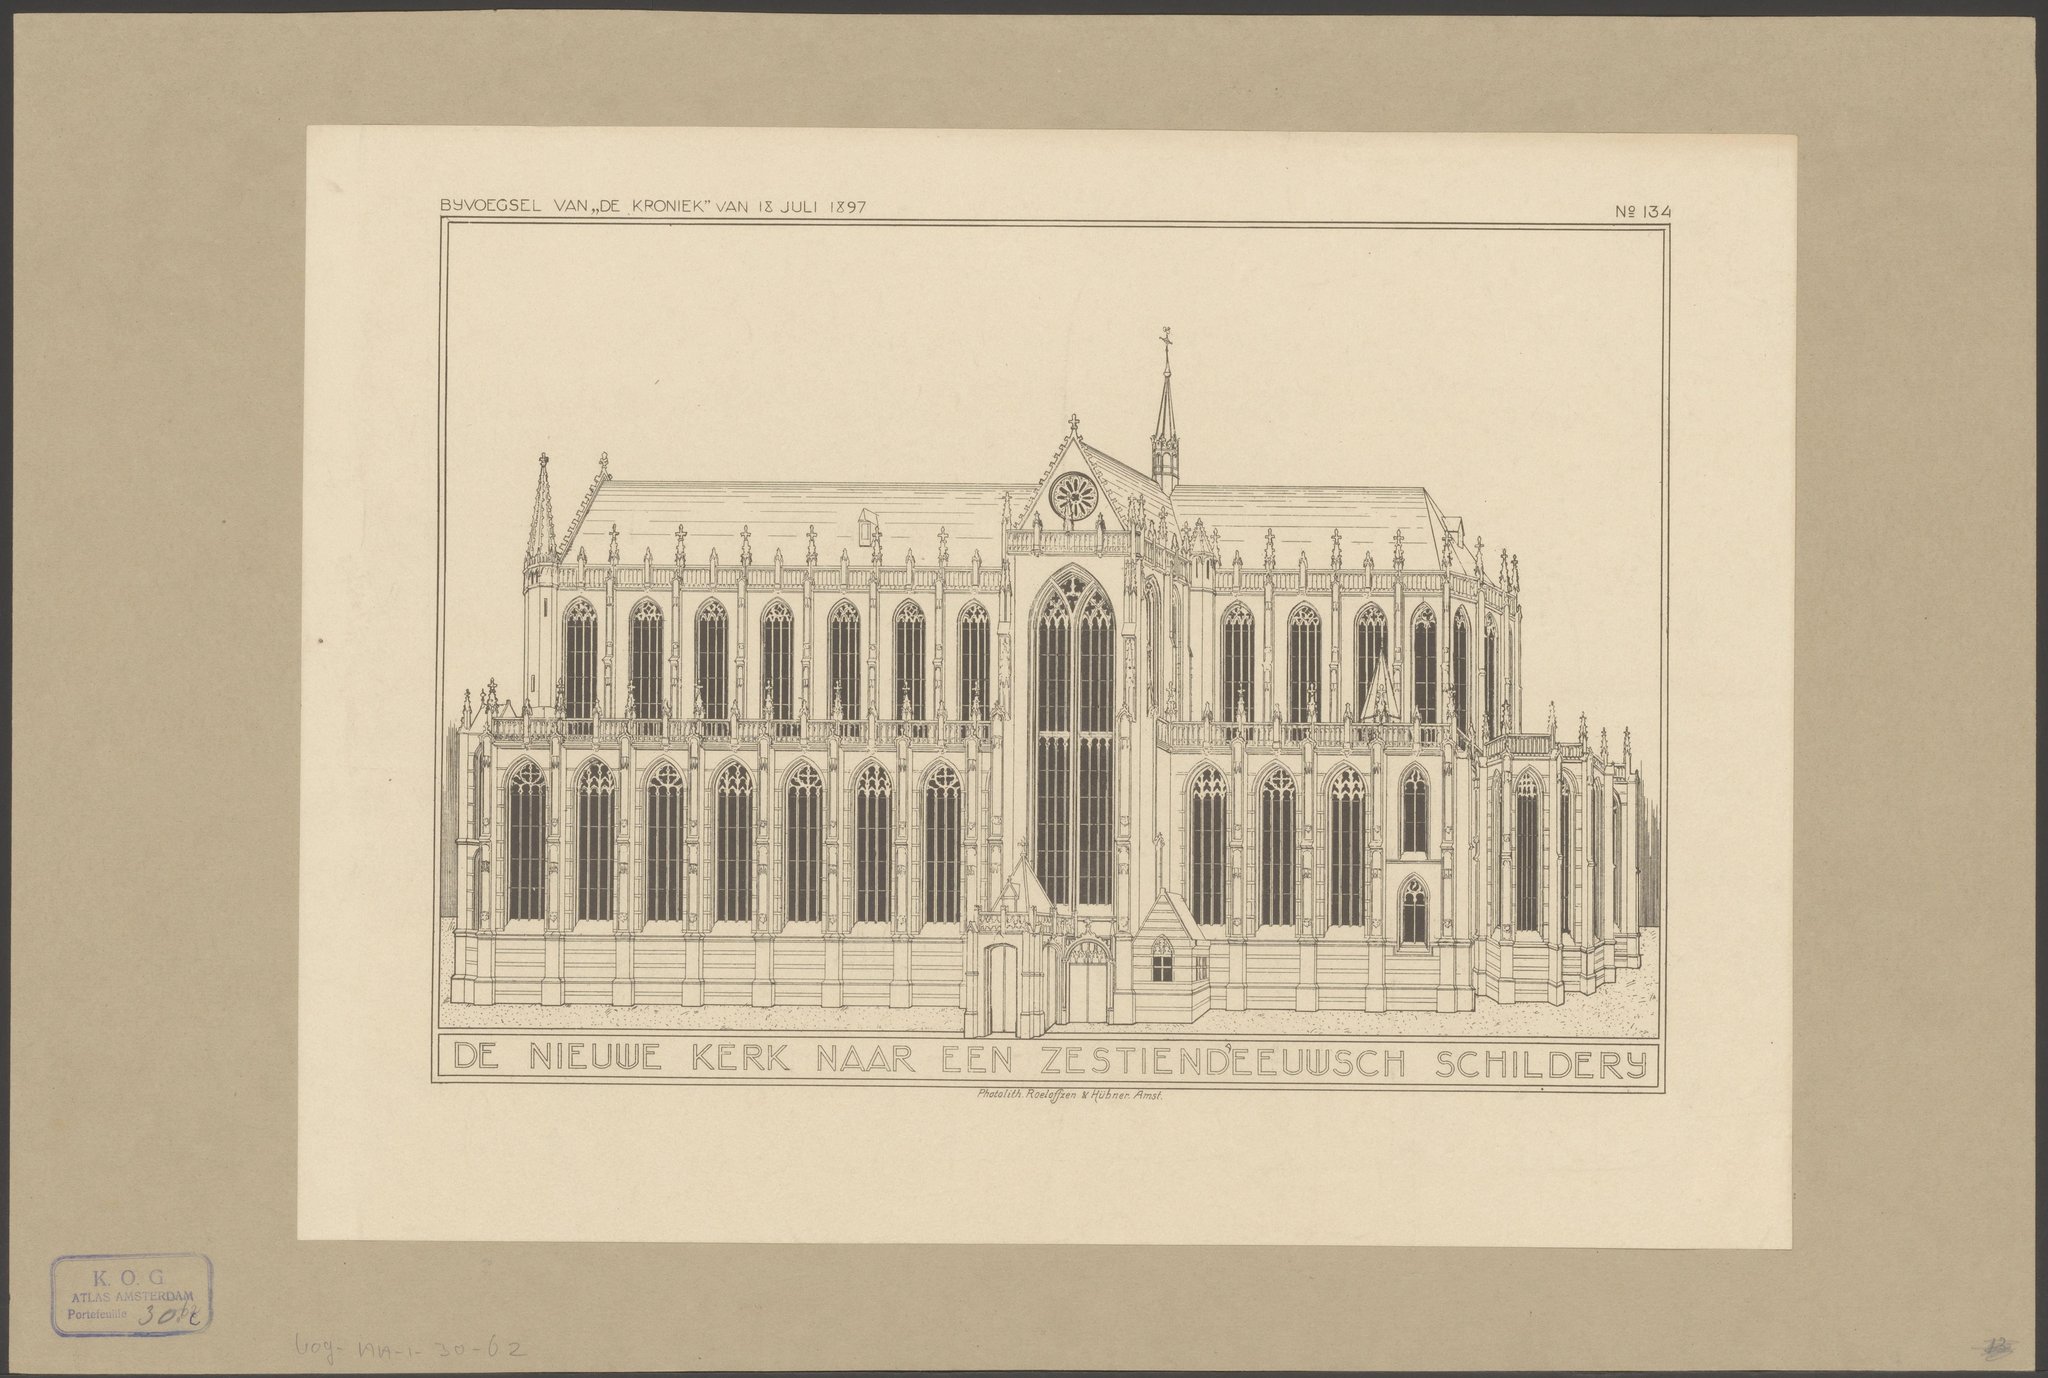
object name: photomechanical print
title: De Nieuwe Kerk naar een zestiend'eeuwsch schildery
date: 1897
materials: paper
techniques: line block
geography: amsterdam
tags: church (exterior)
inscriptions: collector's mark: Lugt 1641b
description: Onderwerpsrubriek binnen de Atlas Amsterdam: Kerkwezen: Hervormde Gemeente: Nieuwe Kerk van buiten.